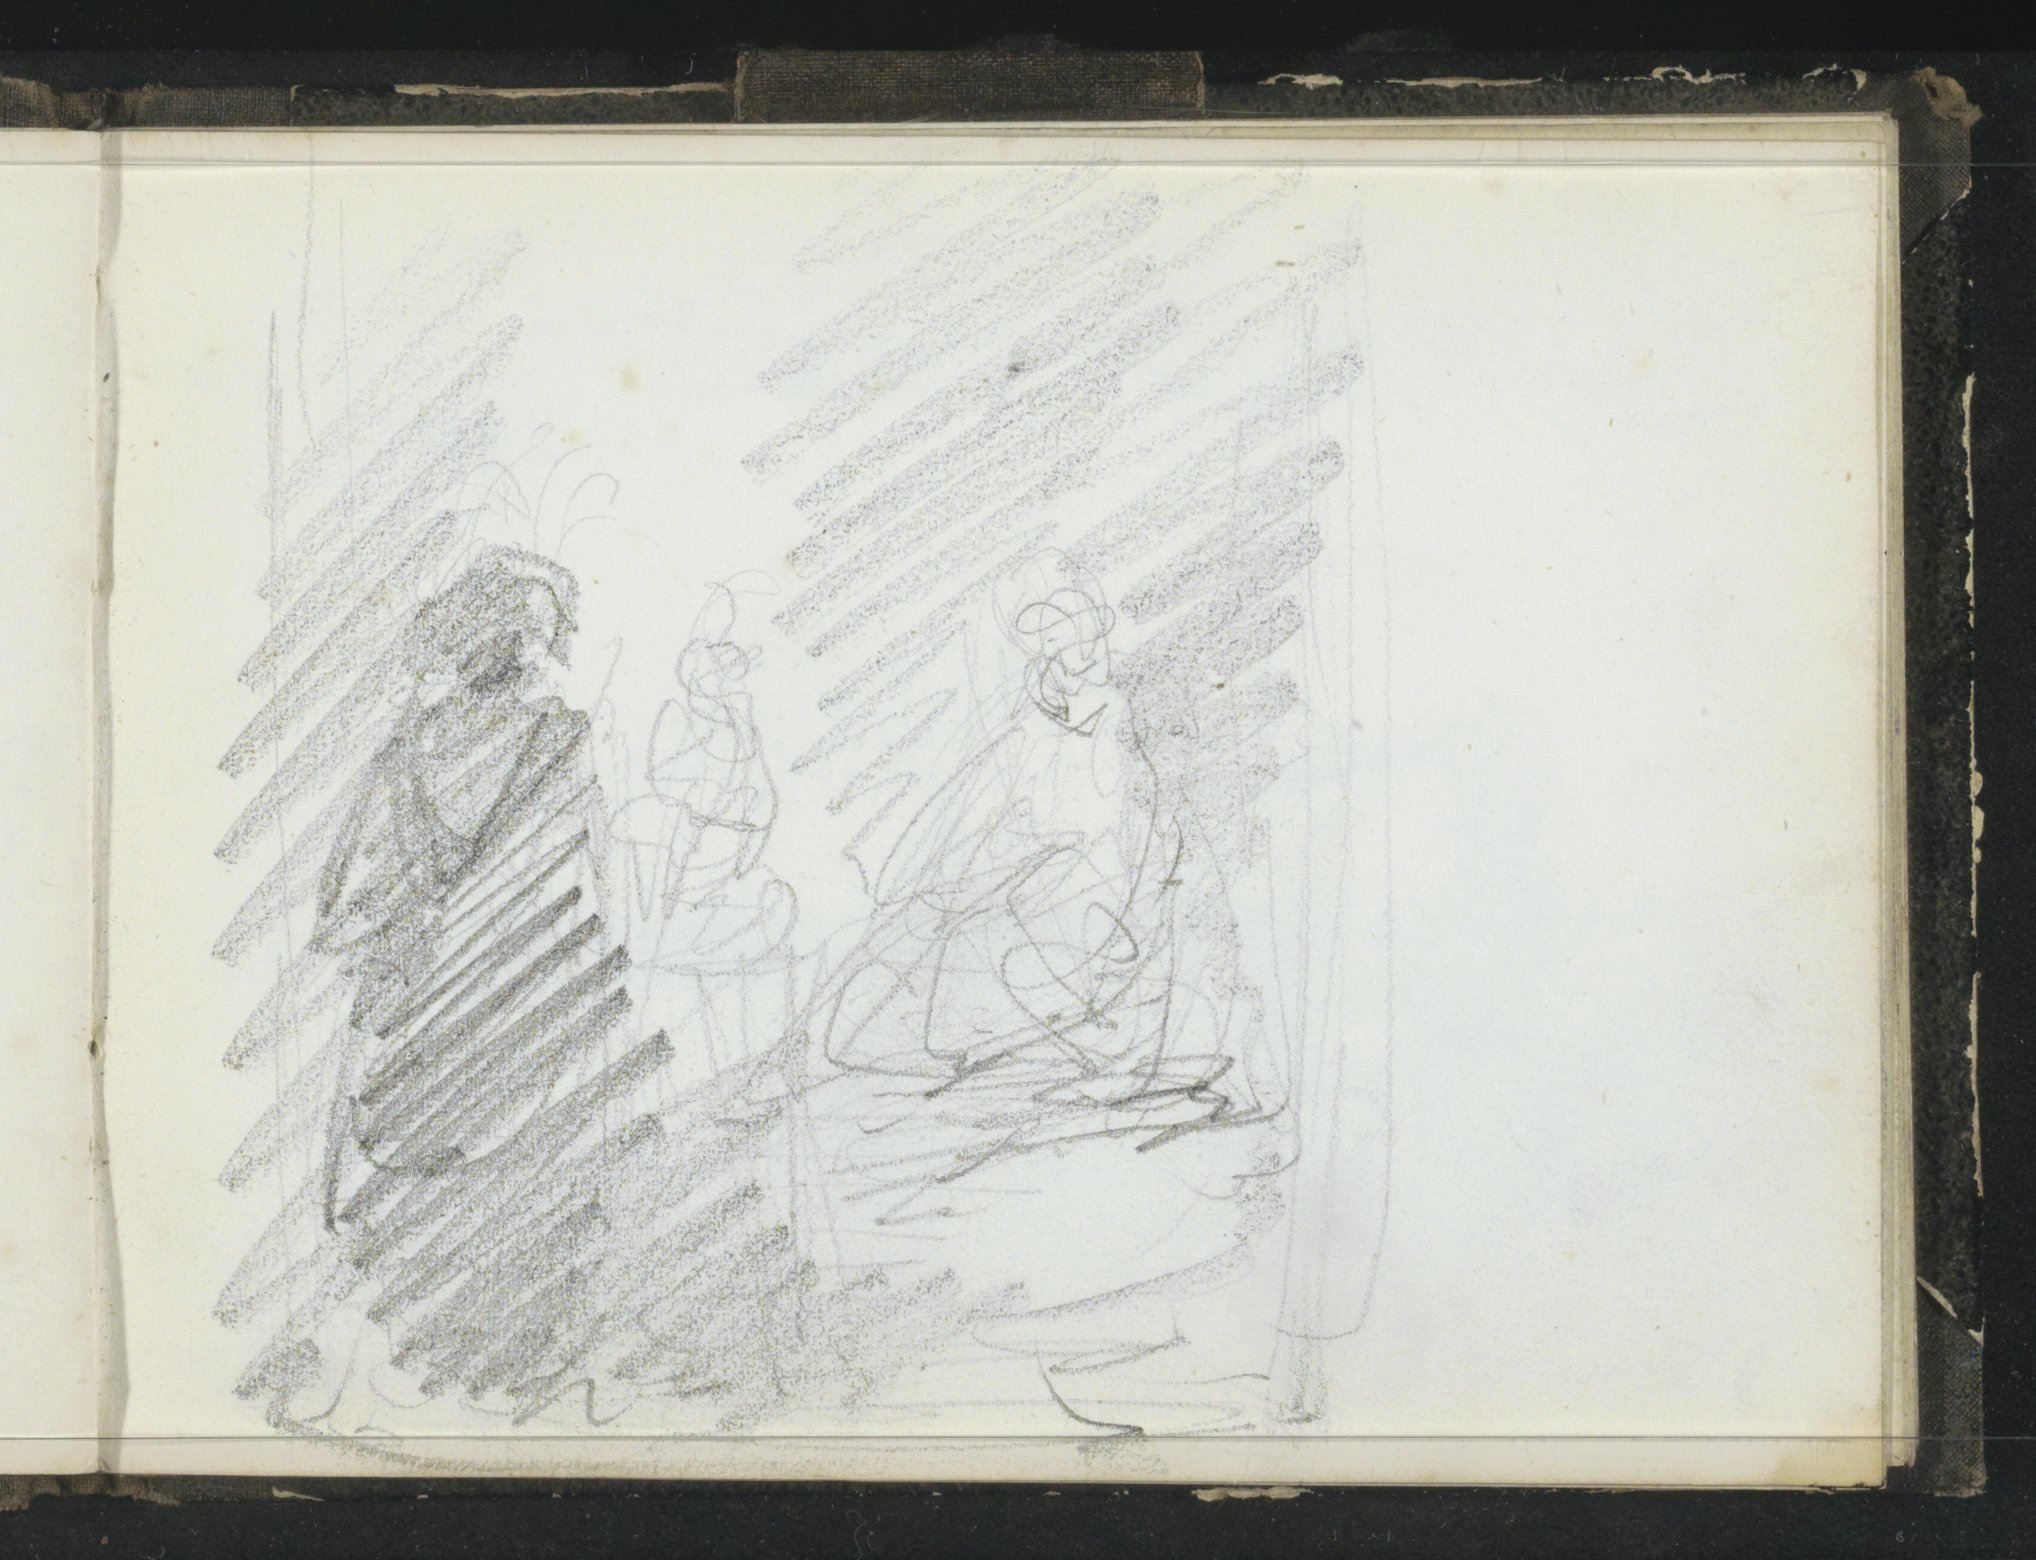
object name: sketchbook leaf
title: Figuurstudies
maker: theo hanrath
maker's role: draughtsman, painter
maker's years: 1853-1883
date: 1879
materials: paper, pencil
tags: anatomy (non-medical)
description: Blad 9 recto uit een schetsboek met 27 bladen.